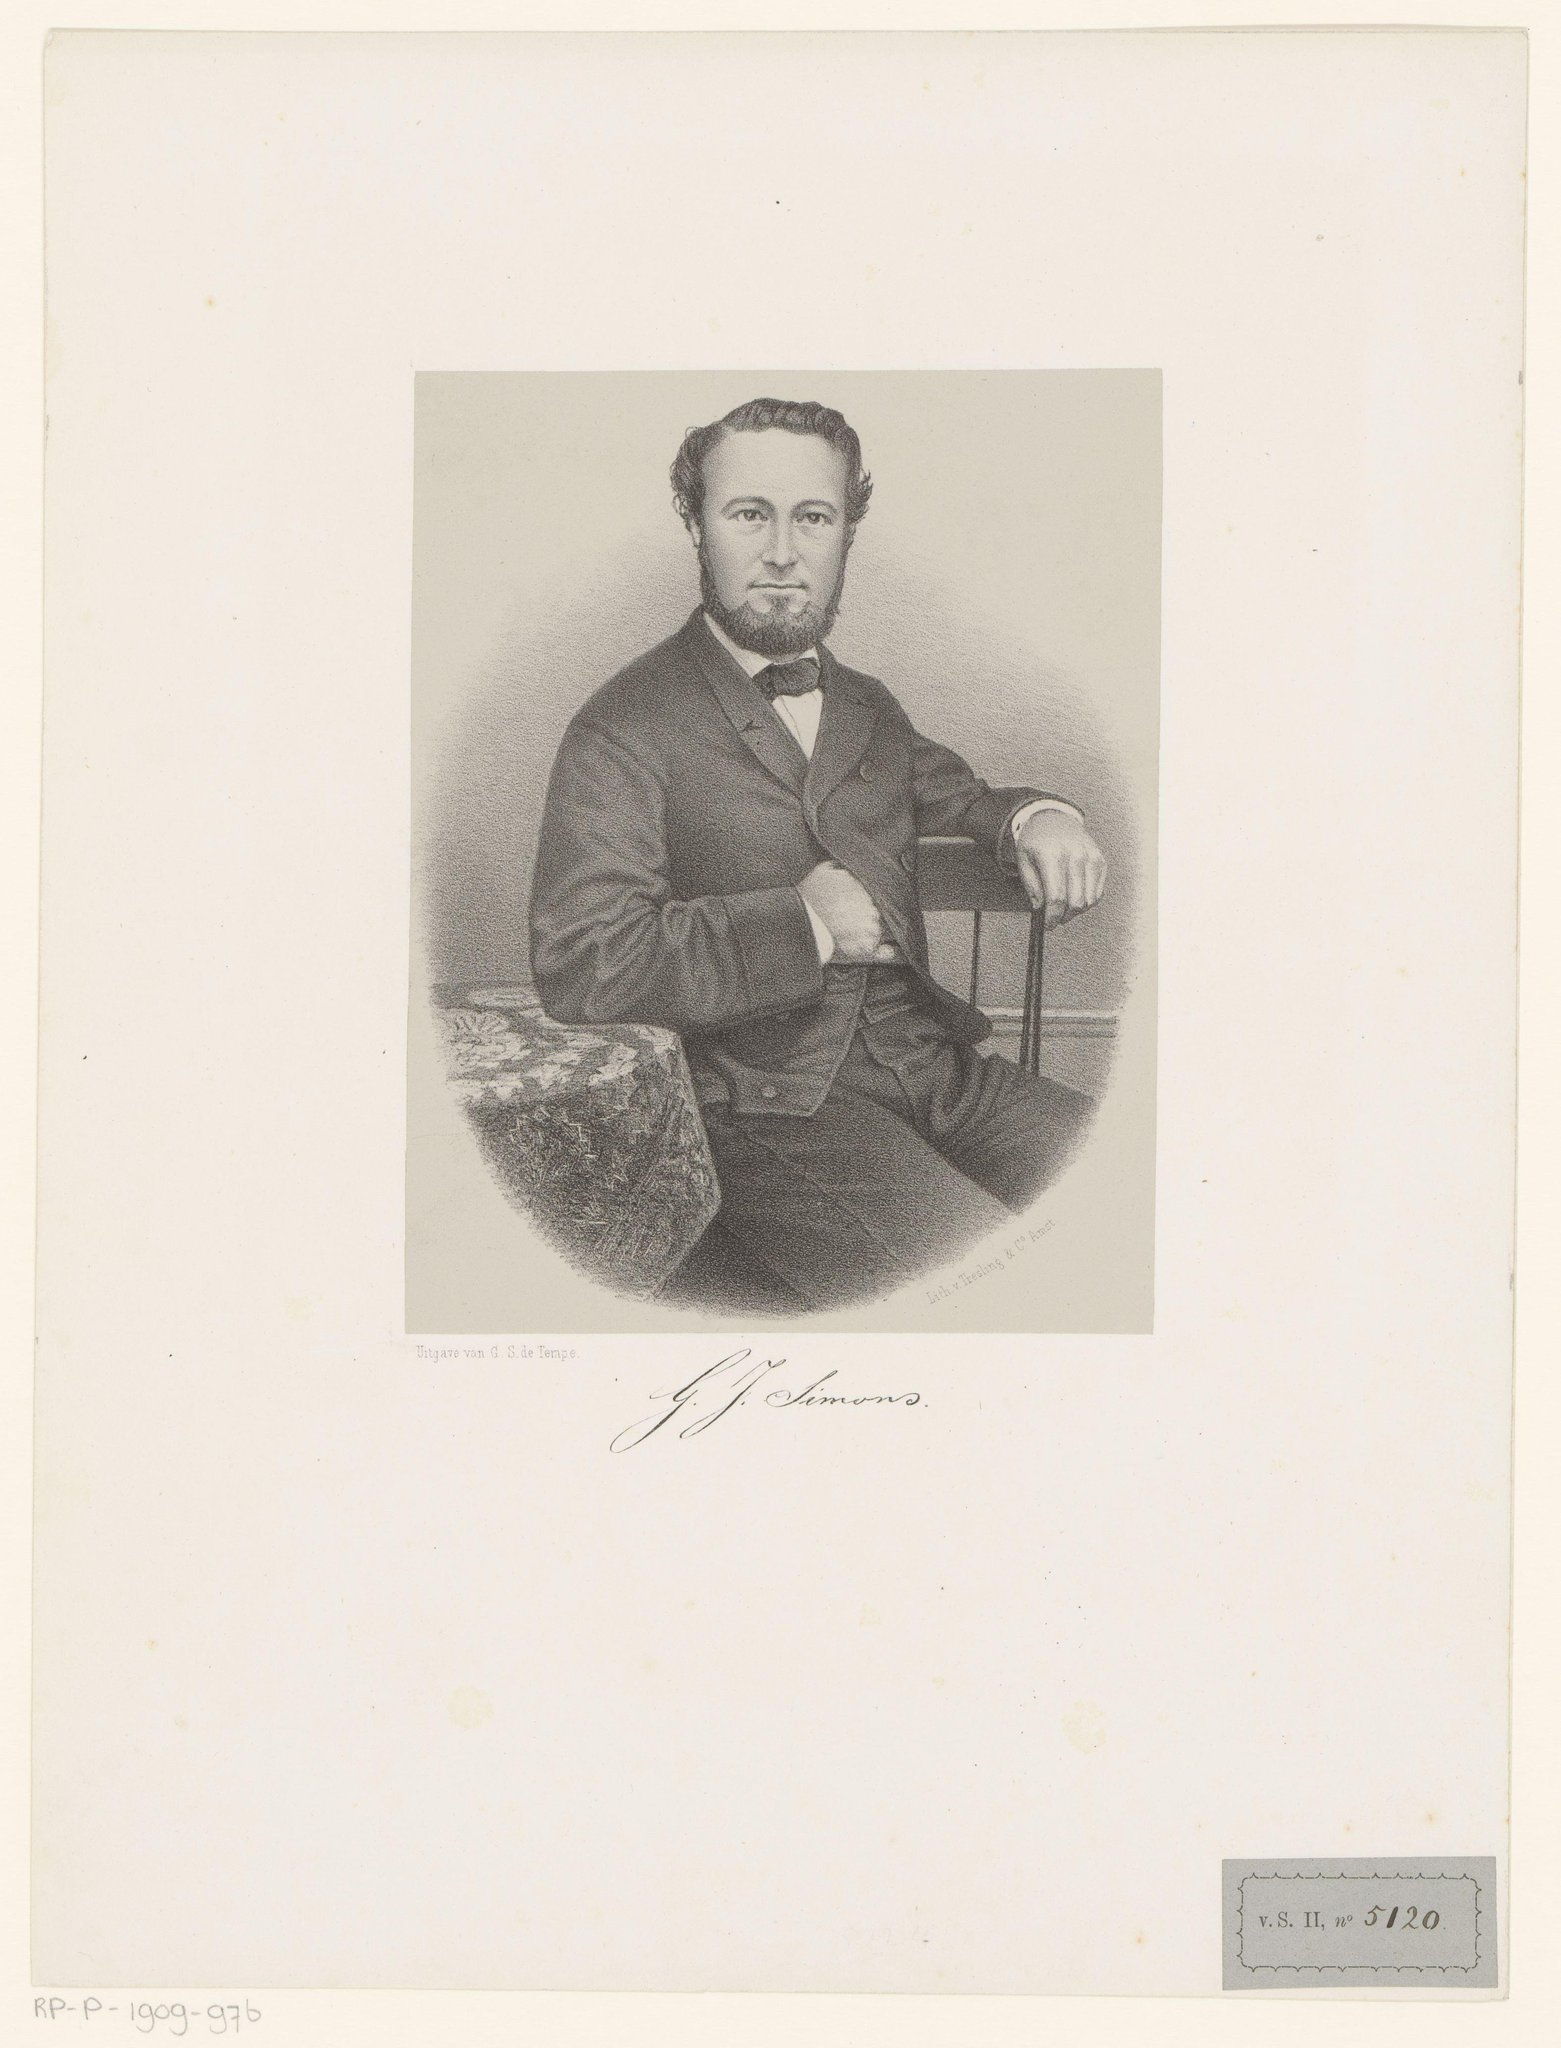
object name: print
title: Portret van Gerardus Johannes Simons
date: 1858-1872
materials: paper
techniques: lithograph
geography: amsterdam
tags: historical persons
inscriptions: collector's mark: Lugt 2228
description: Onder het portret de signatuur van de geportretteerde.